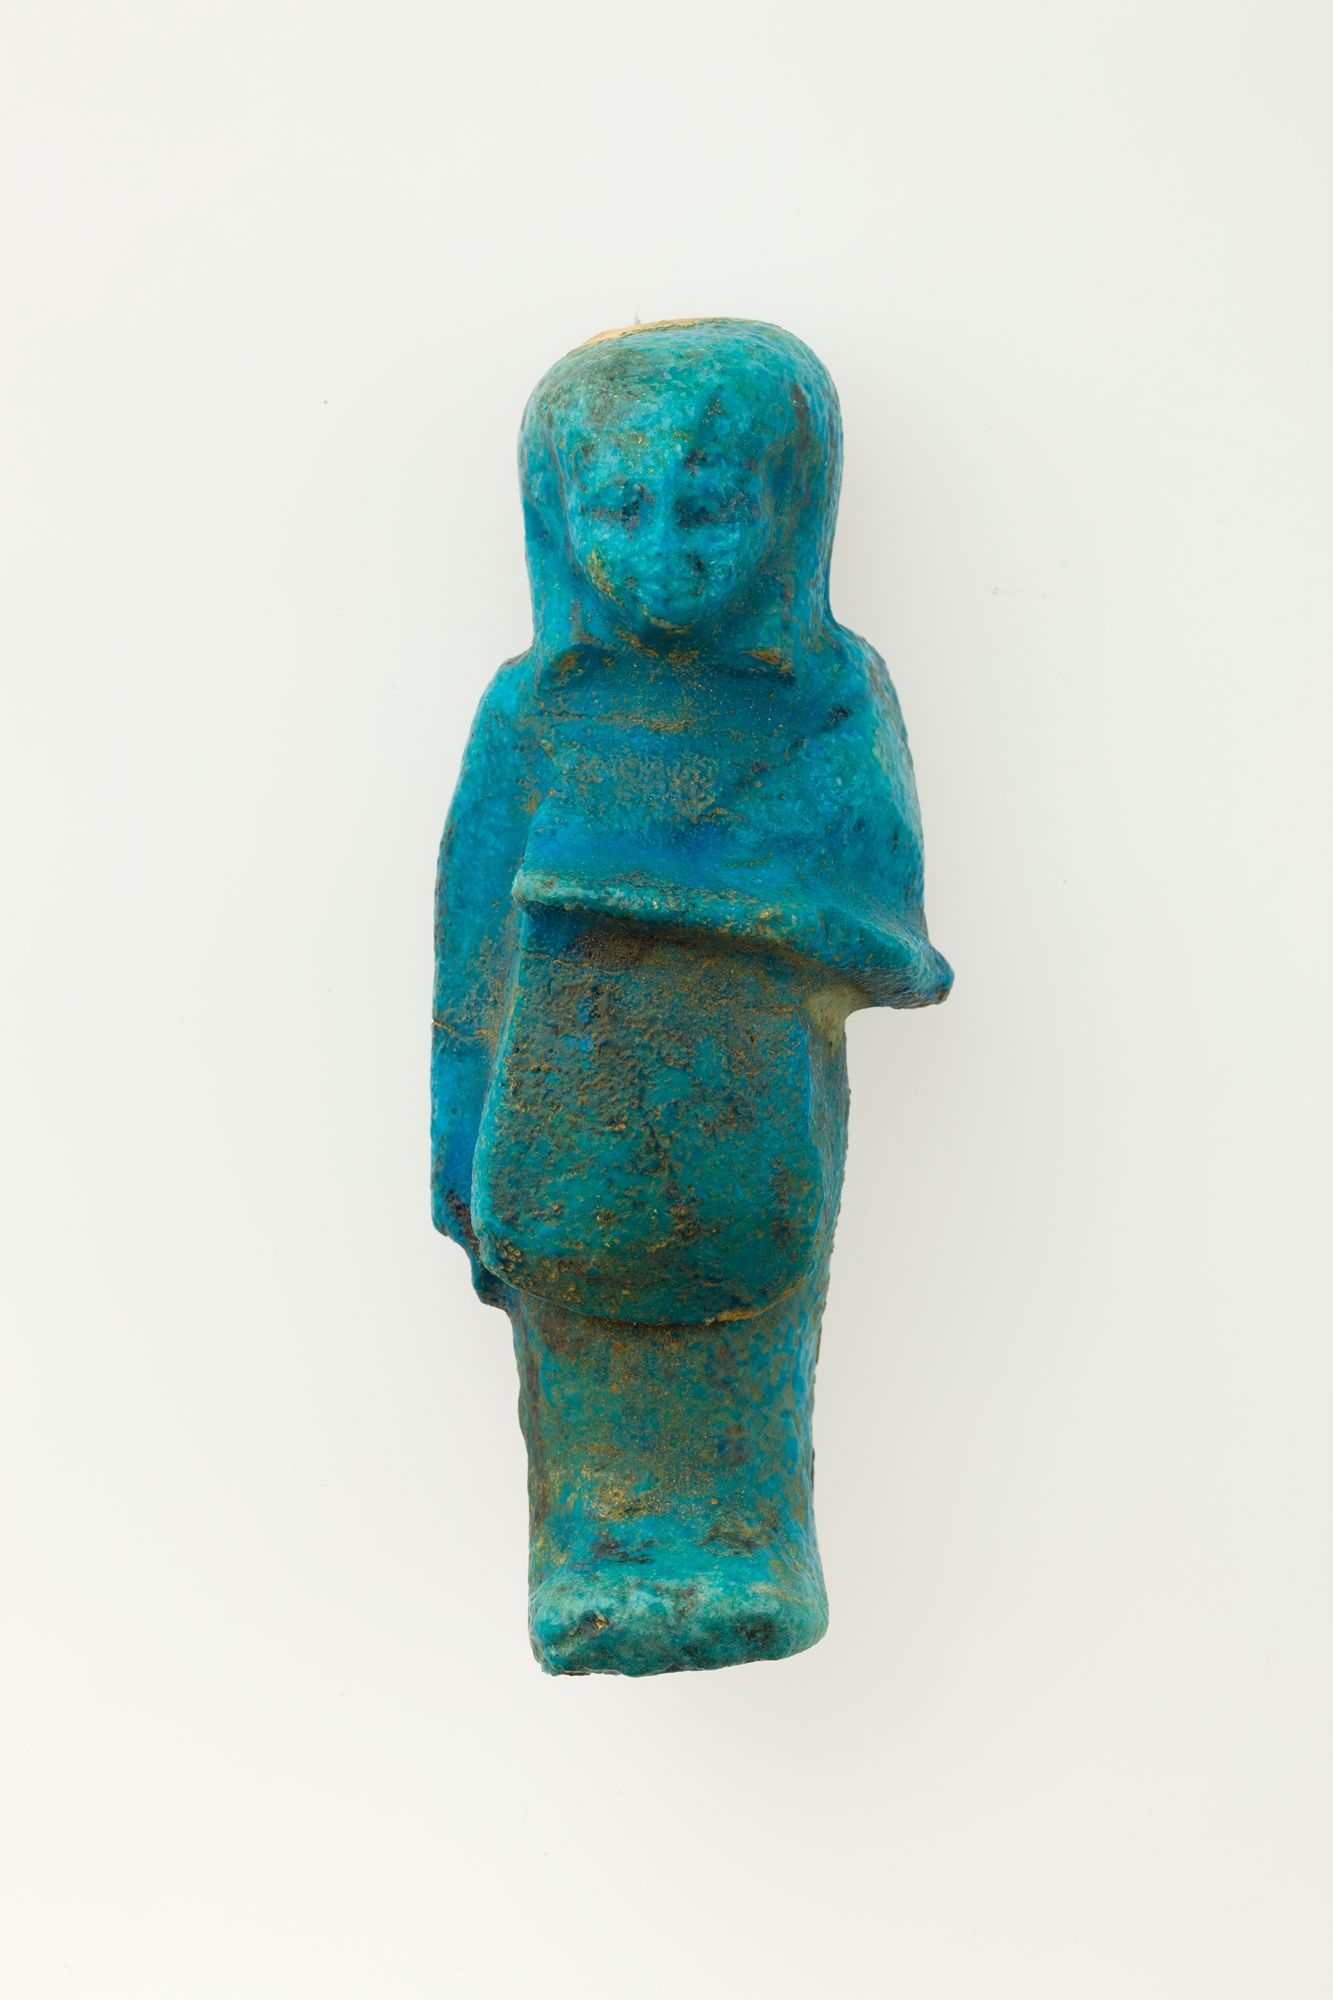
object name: shabti, henettawy c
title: Overseer Shabti of Henettawy (C), Daughter of Isetemkheb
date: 990-970 BCE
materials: faience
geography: egypt